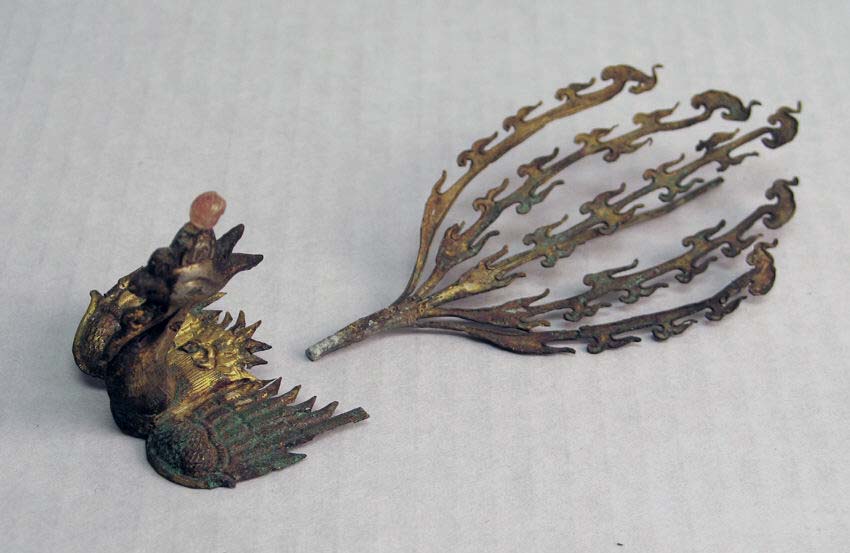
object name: ornament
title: Phoenix Ornament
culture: chinese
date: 960-1279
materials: silver gilt, gemstone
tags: phoenix